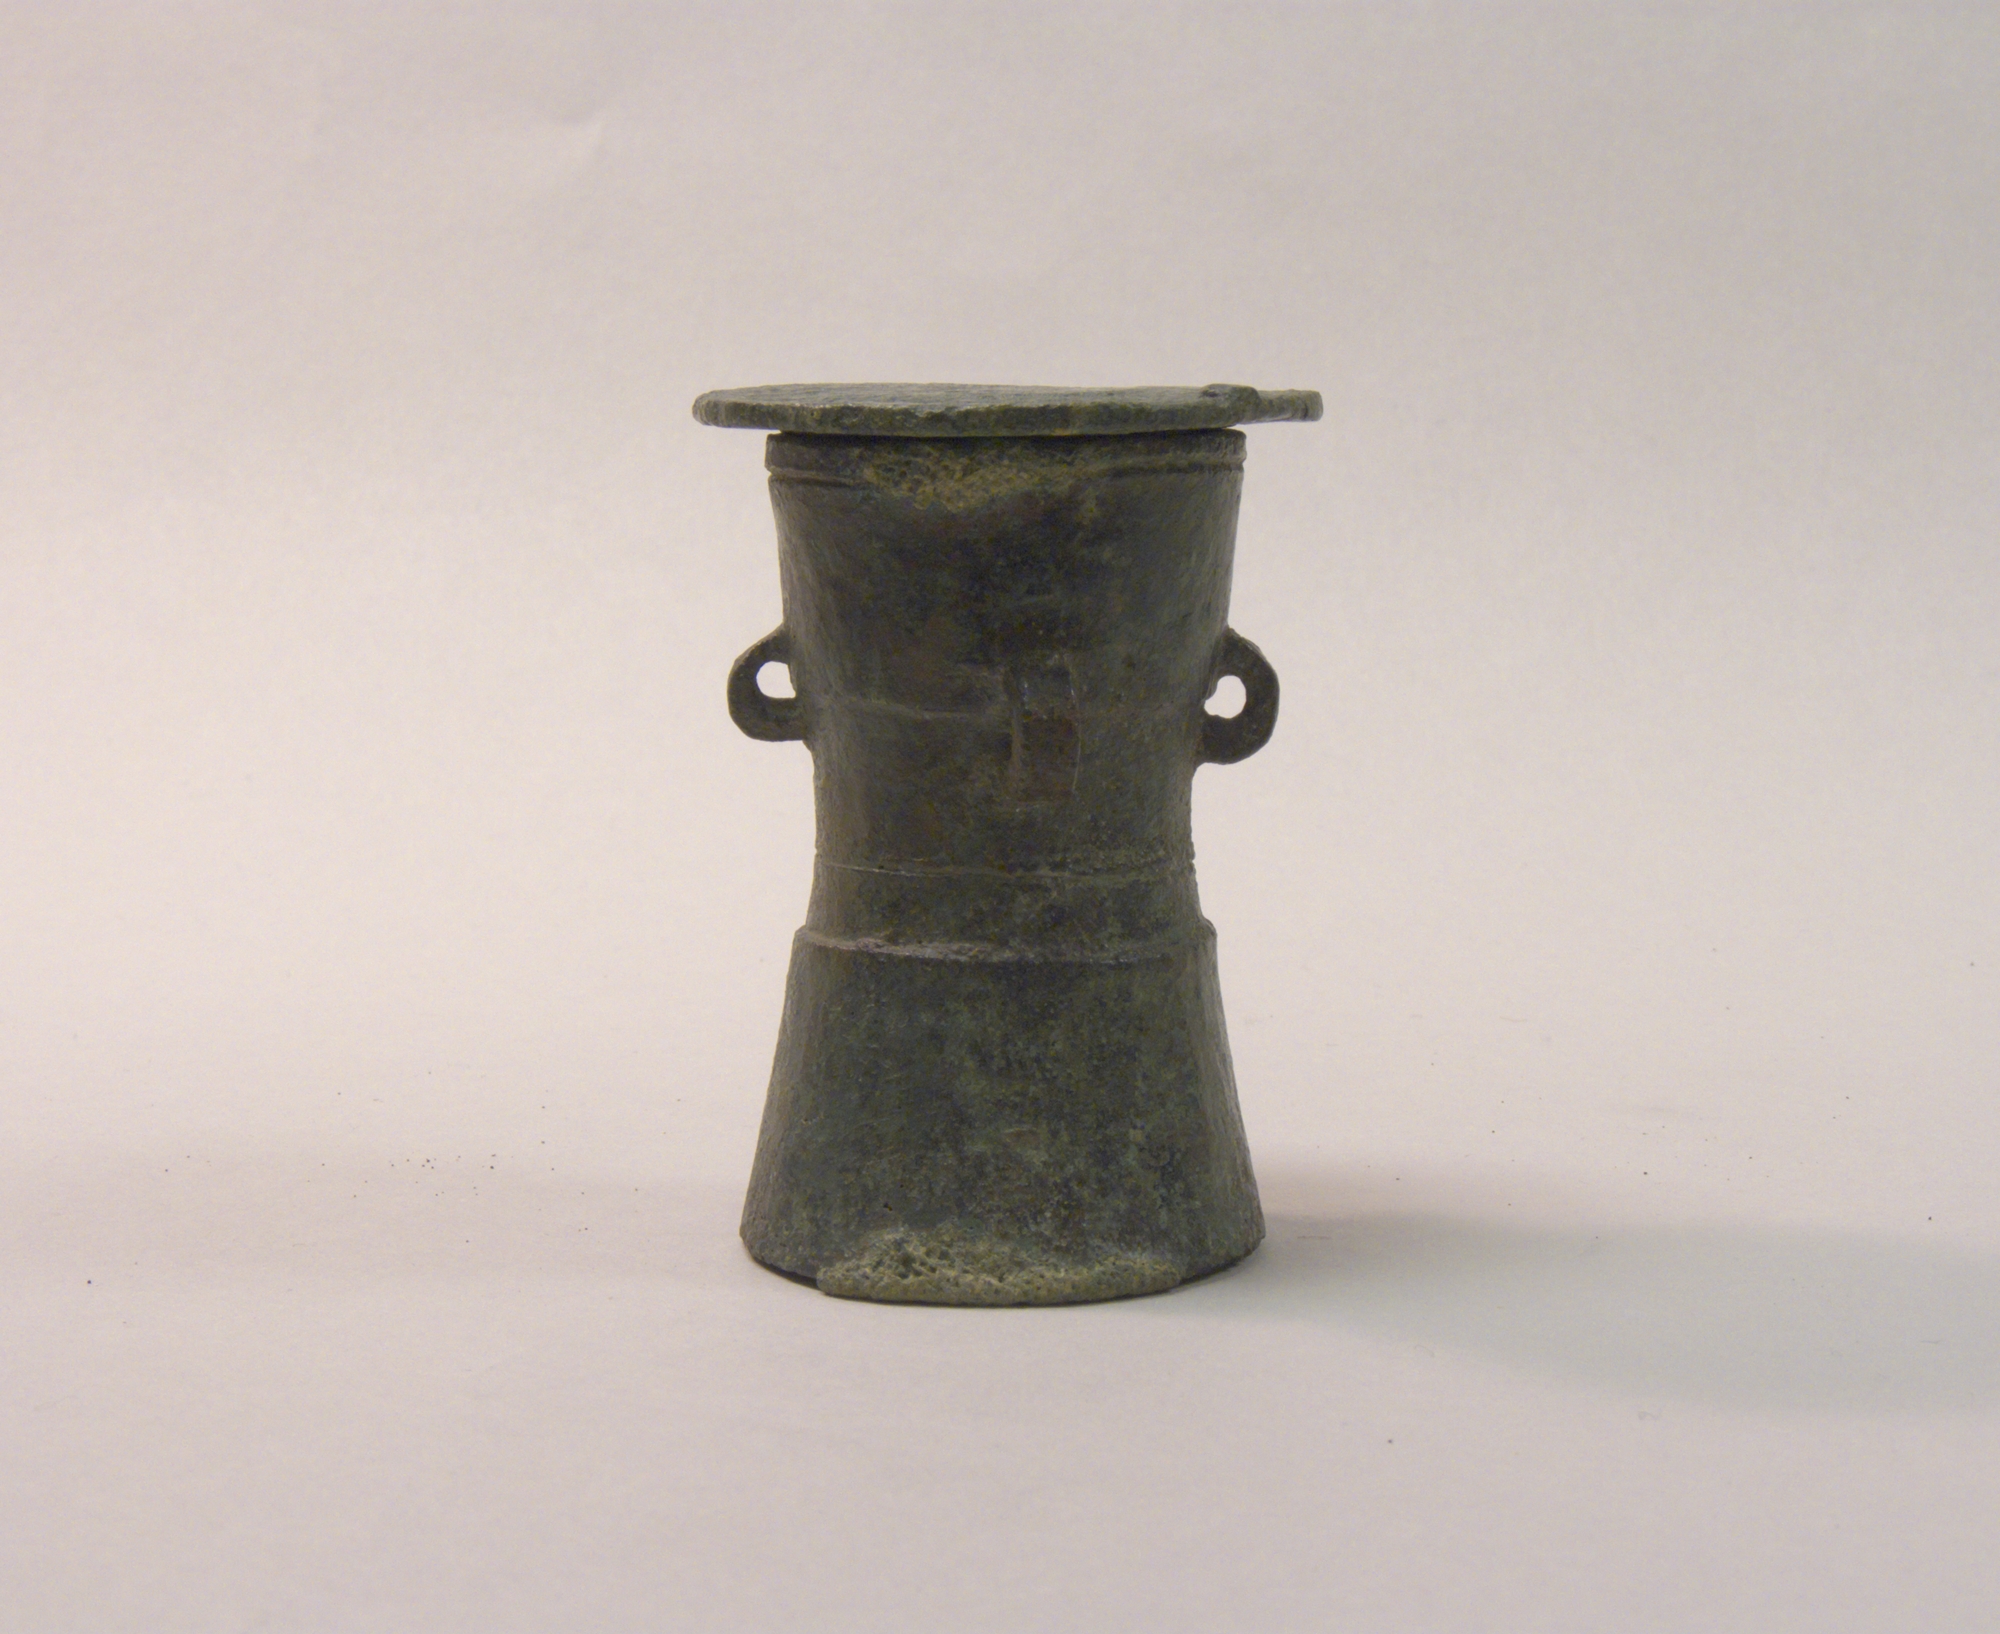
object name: lime container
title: Lime Container in the Shape of a "Mioko" Drum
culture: indonesian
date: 500 BCE-300 CE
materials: bronze